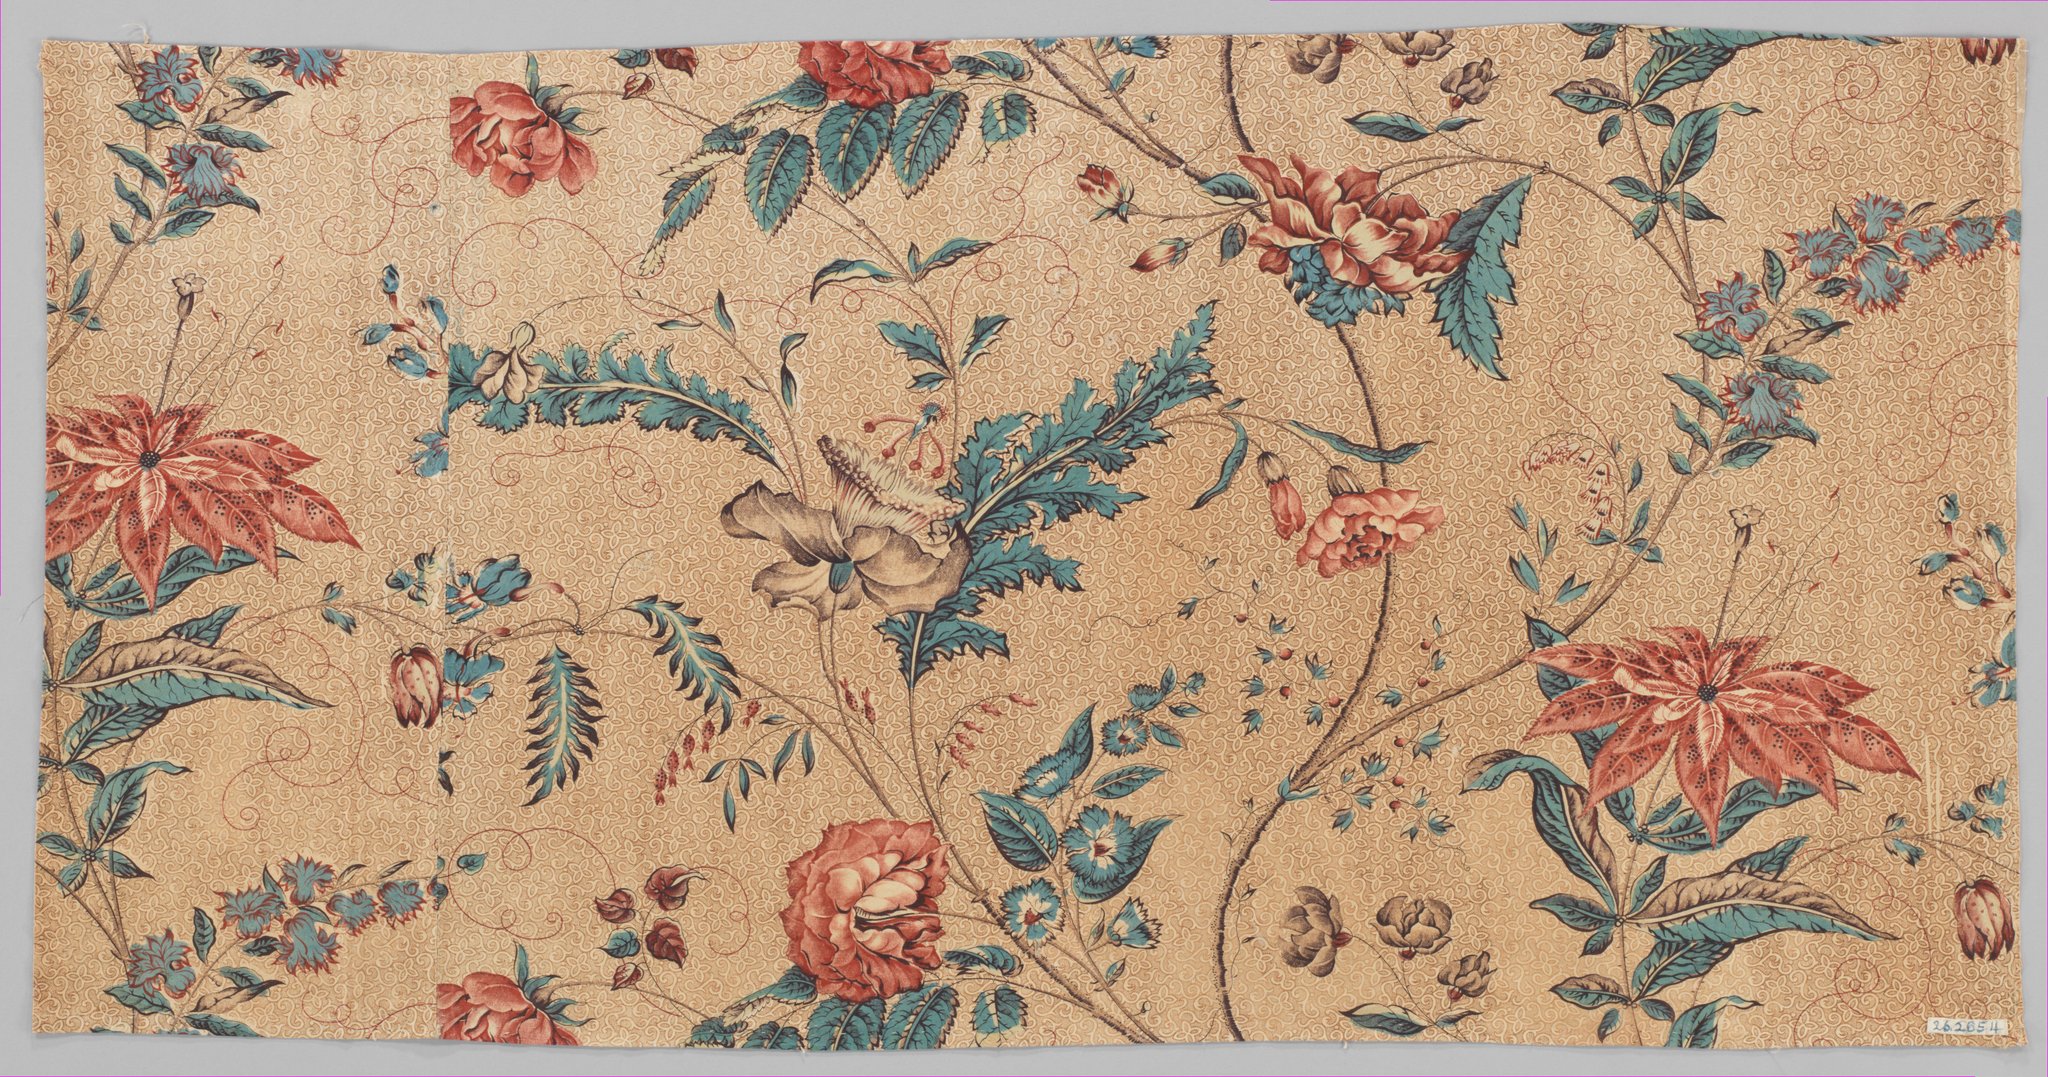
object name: piece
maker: bannister hall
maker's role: manufactory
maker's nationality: british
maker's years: 1793-1893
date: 1830-1835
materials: cotton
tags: flowers